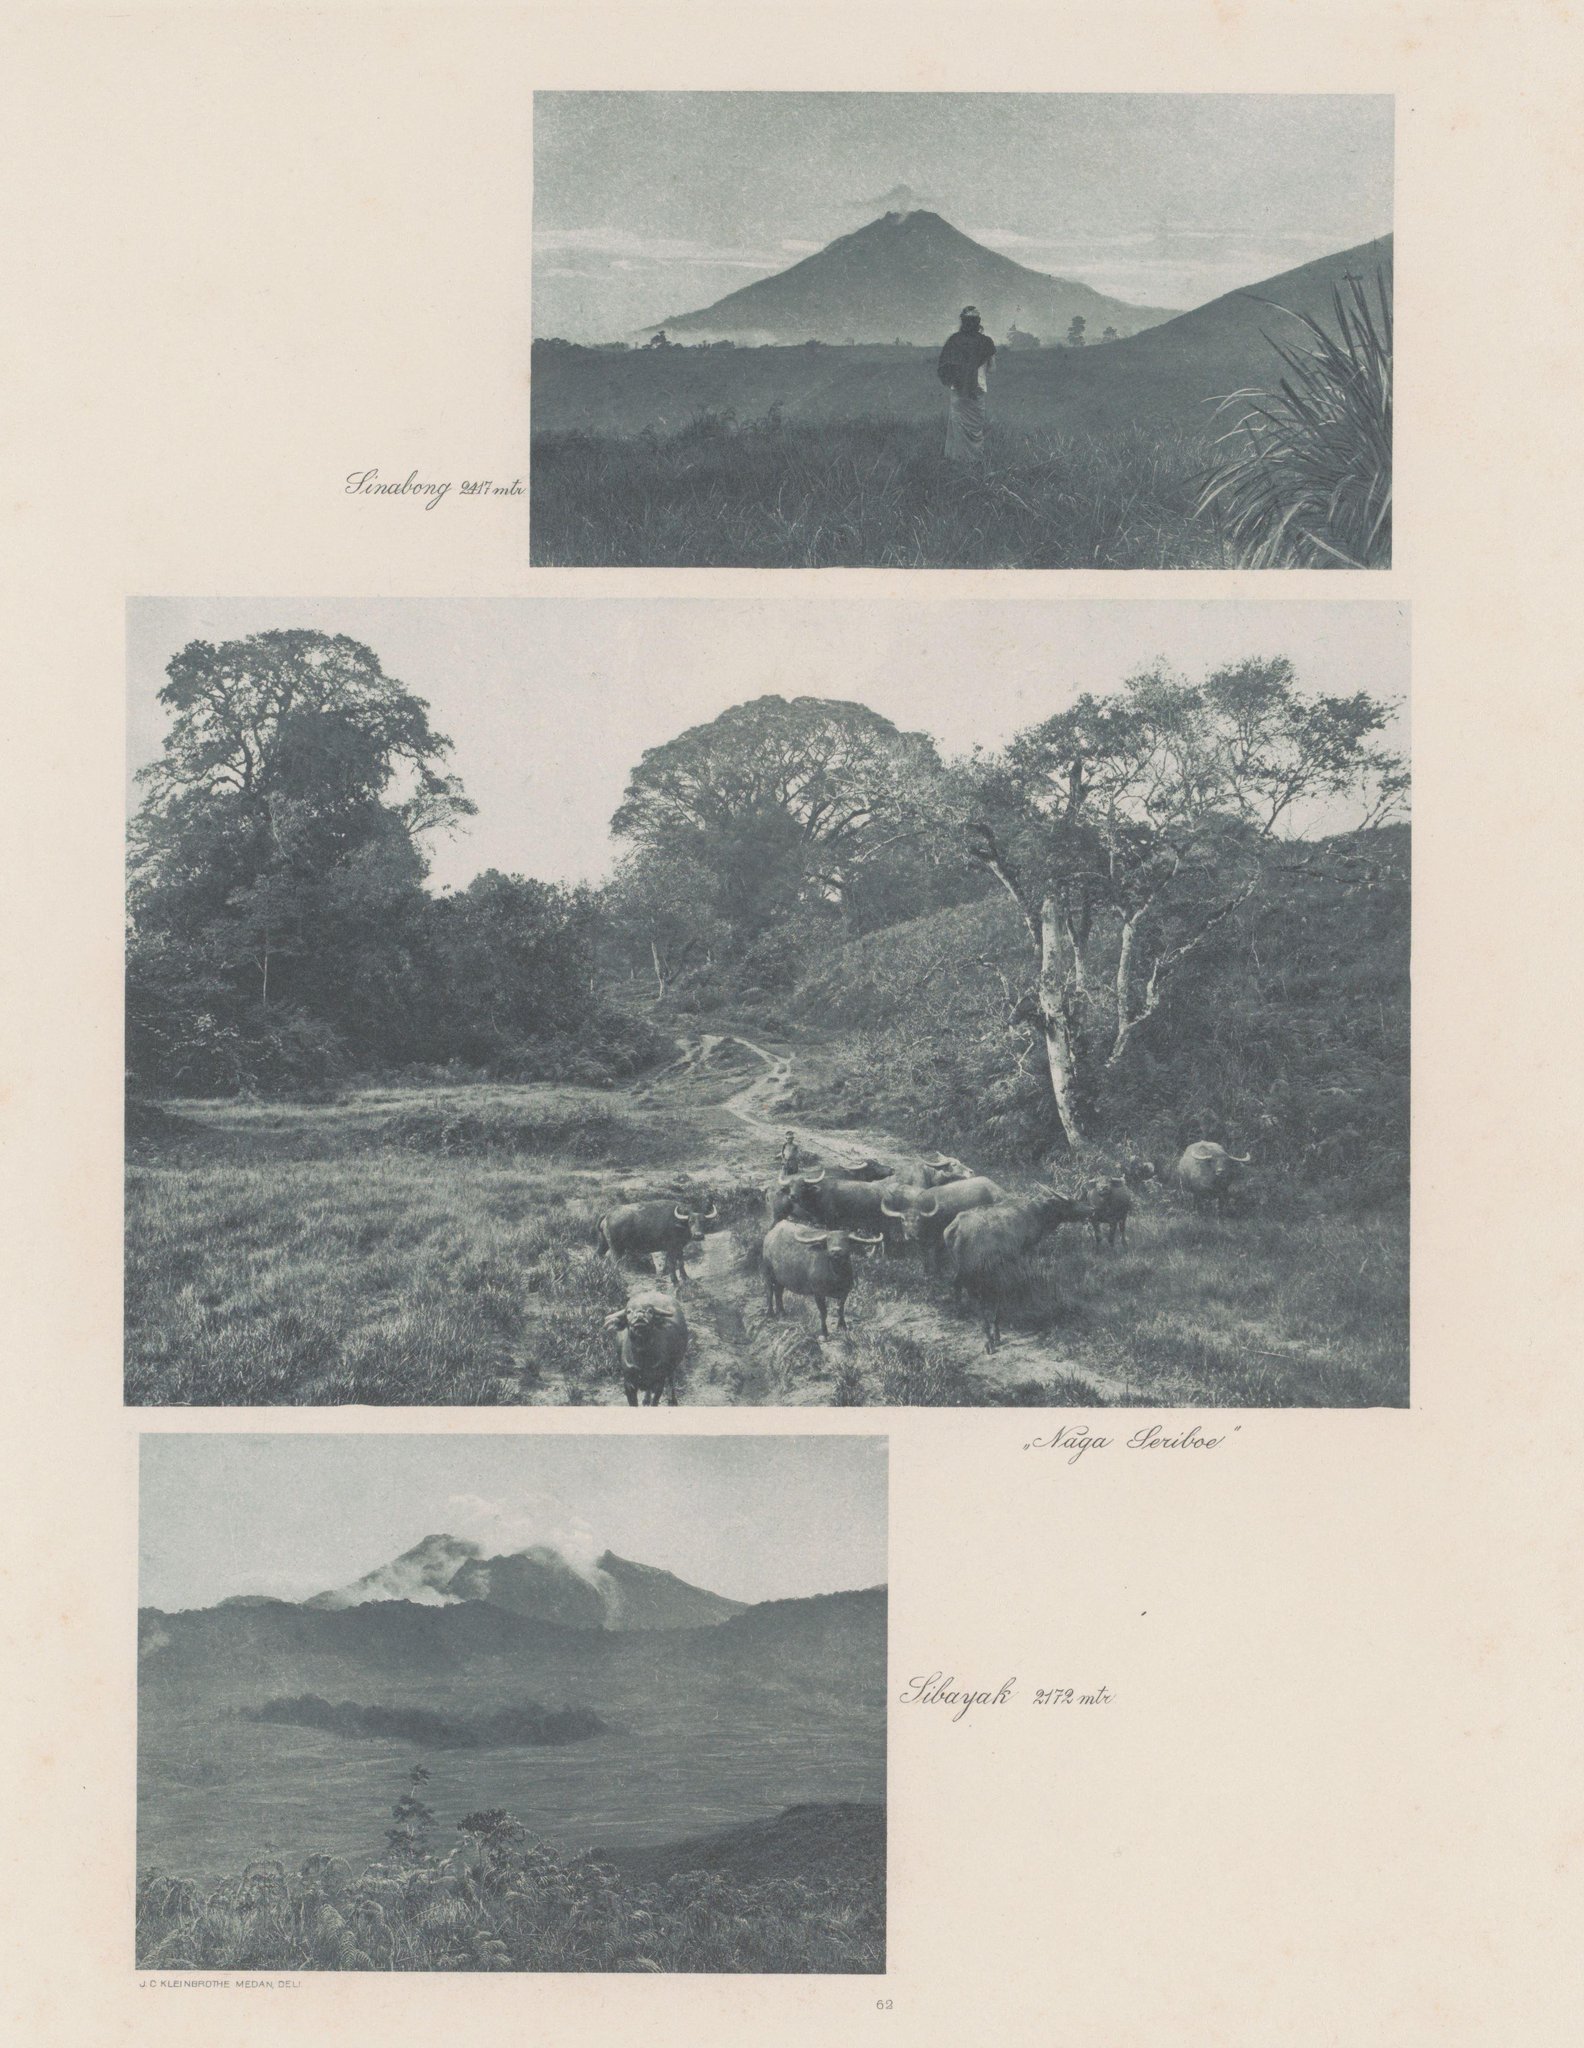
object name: photomechanical print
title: Sinabong 2417 mtr (boven), „Naga Seriboe" (midden), Sibayak 2172 mtr (onder)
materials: paper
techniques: photoaquatint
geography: munich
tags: hoofed animals: buffalo, volcano, eruption (of volcano), sumatra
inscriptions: number: ‘62’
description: Onderdeel van Album met heliogravures van Sumatra's oostkust.